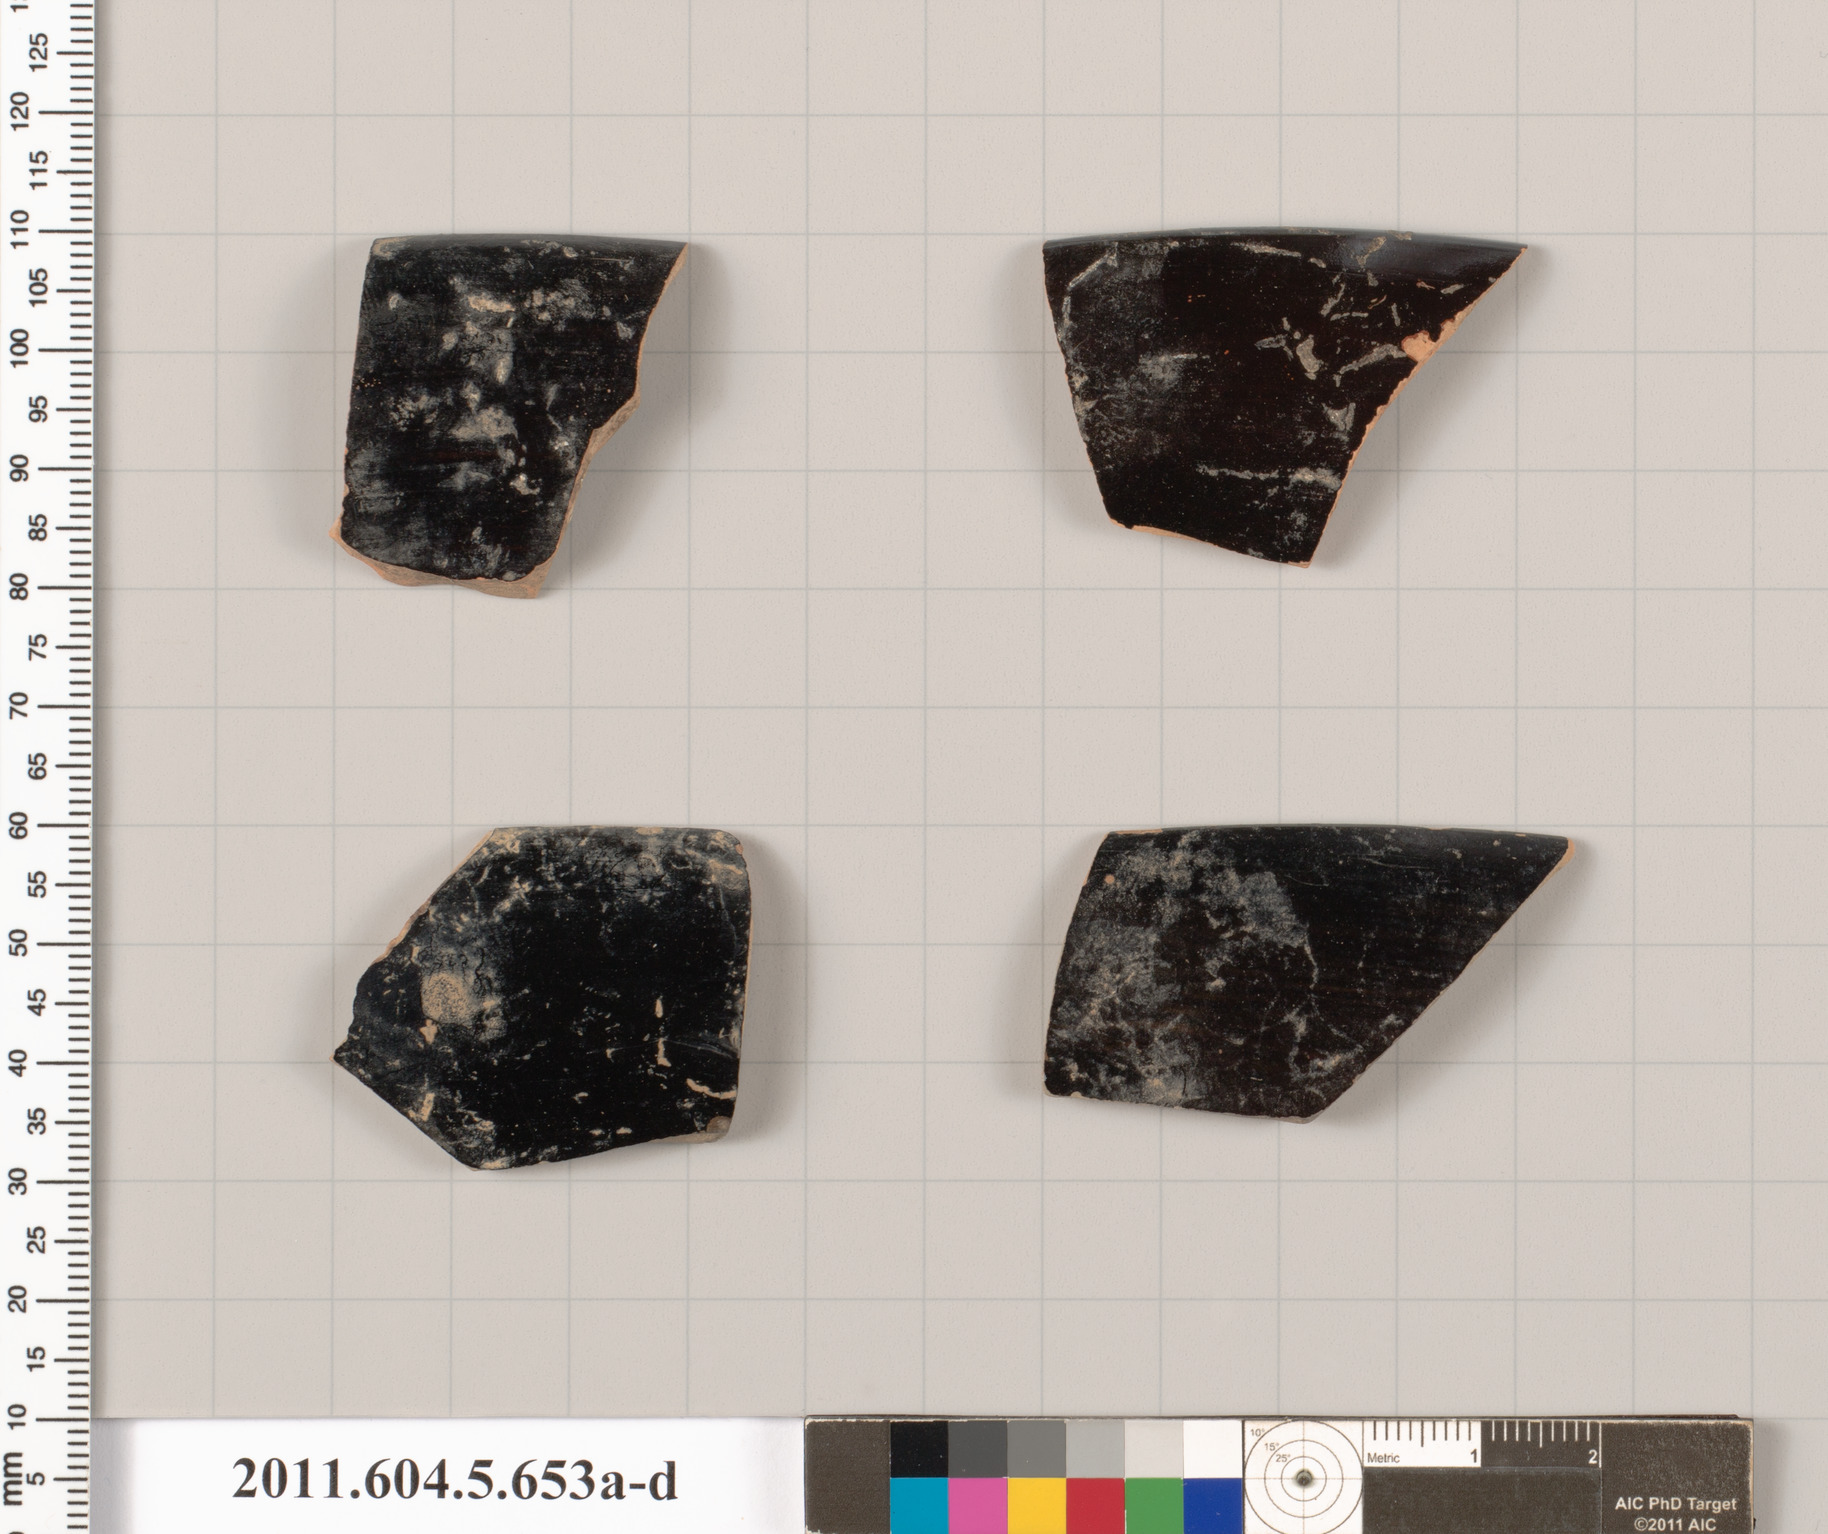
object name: kylix fragment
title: Terracotta rim fragments of kylikes (drinking cups)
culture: greek, attic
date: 600-401 BCE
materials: terracotta